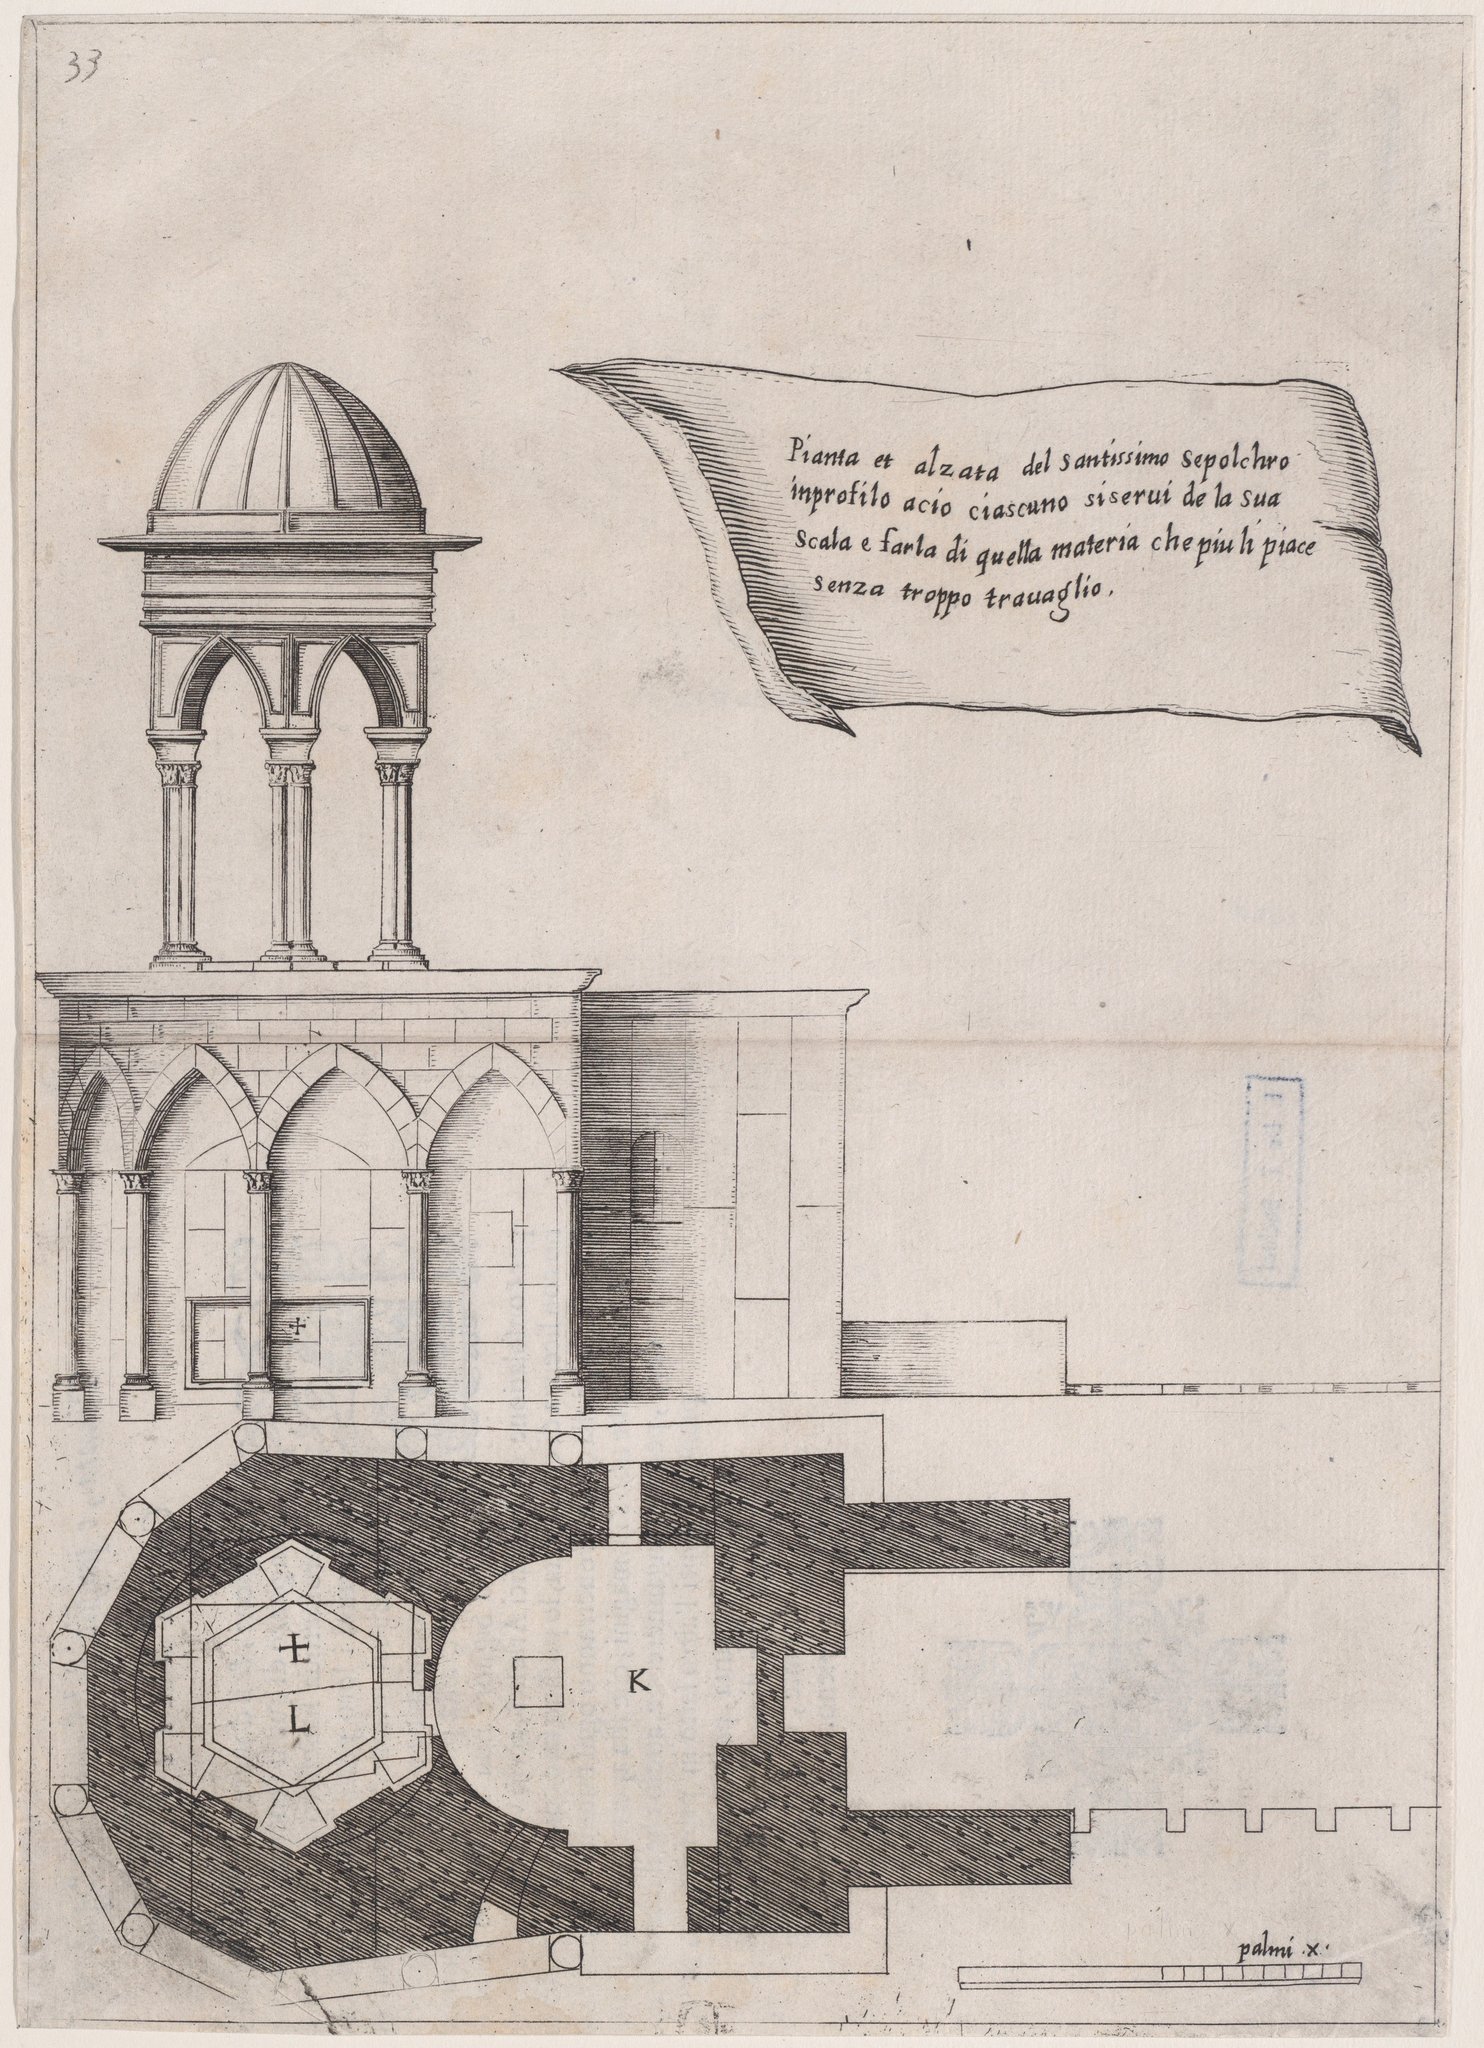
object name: print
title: Plate 26, from "Trattato delle Piante & Immagini de Sacri Edifizi di Terra Santa" (Treatise of the Plans & Images of the Sacred Buildings of the Holy Land)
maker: jacques callot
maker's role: artist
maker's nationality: french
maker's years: 1592-1635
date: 1620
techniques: engraving, etching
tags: architecture,buildings